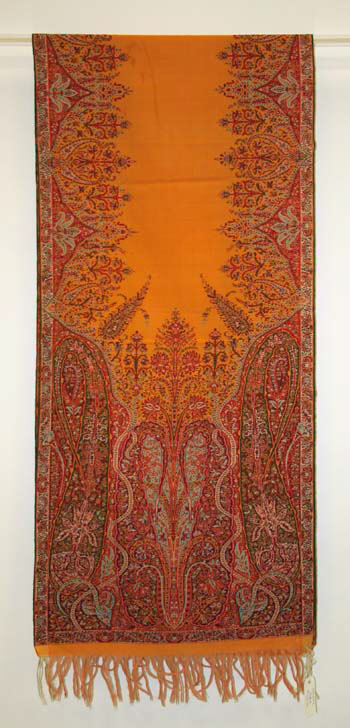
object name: shawl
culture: british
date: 1800-1850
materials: cotton, silk